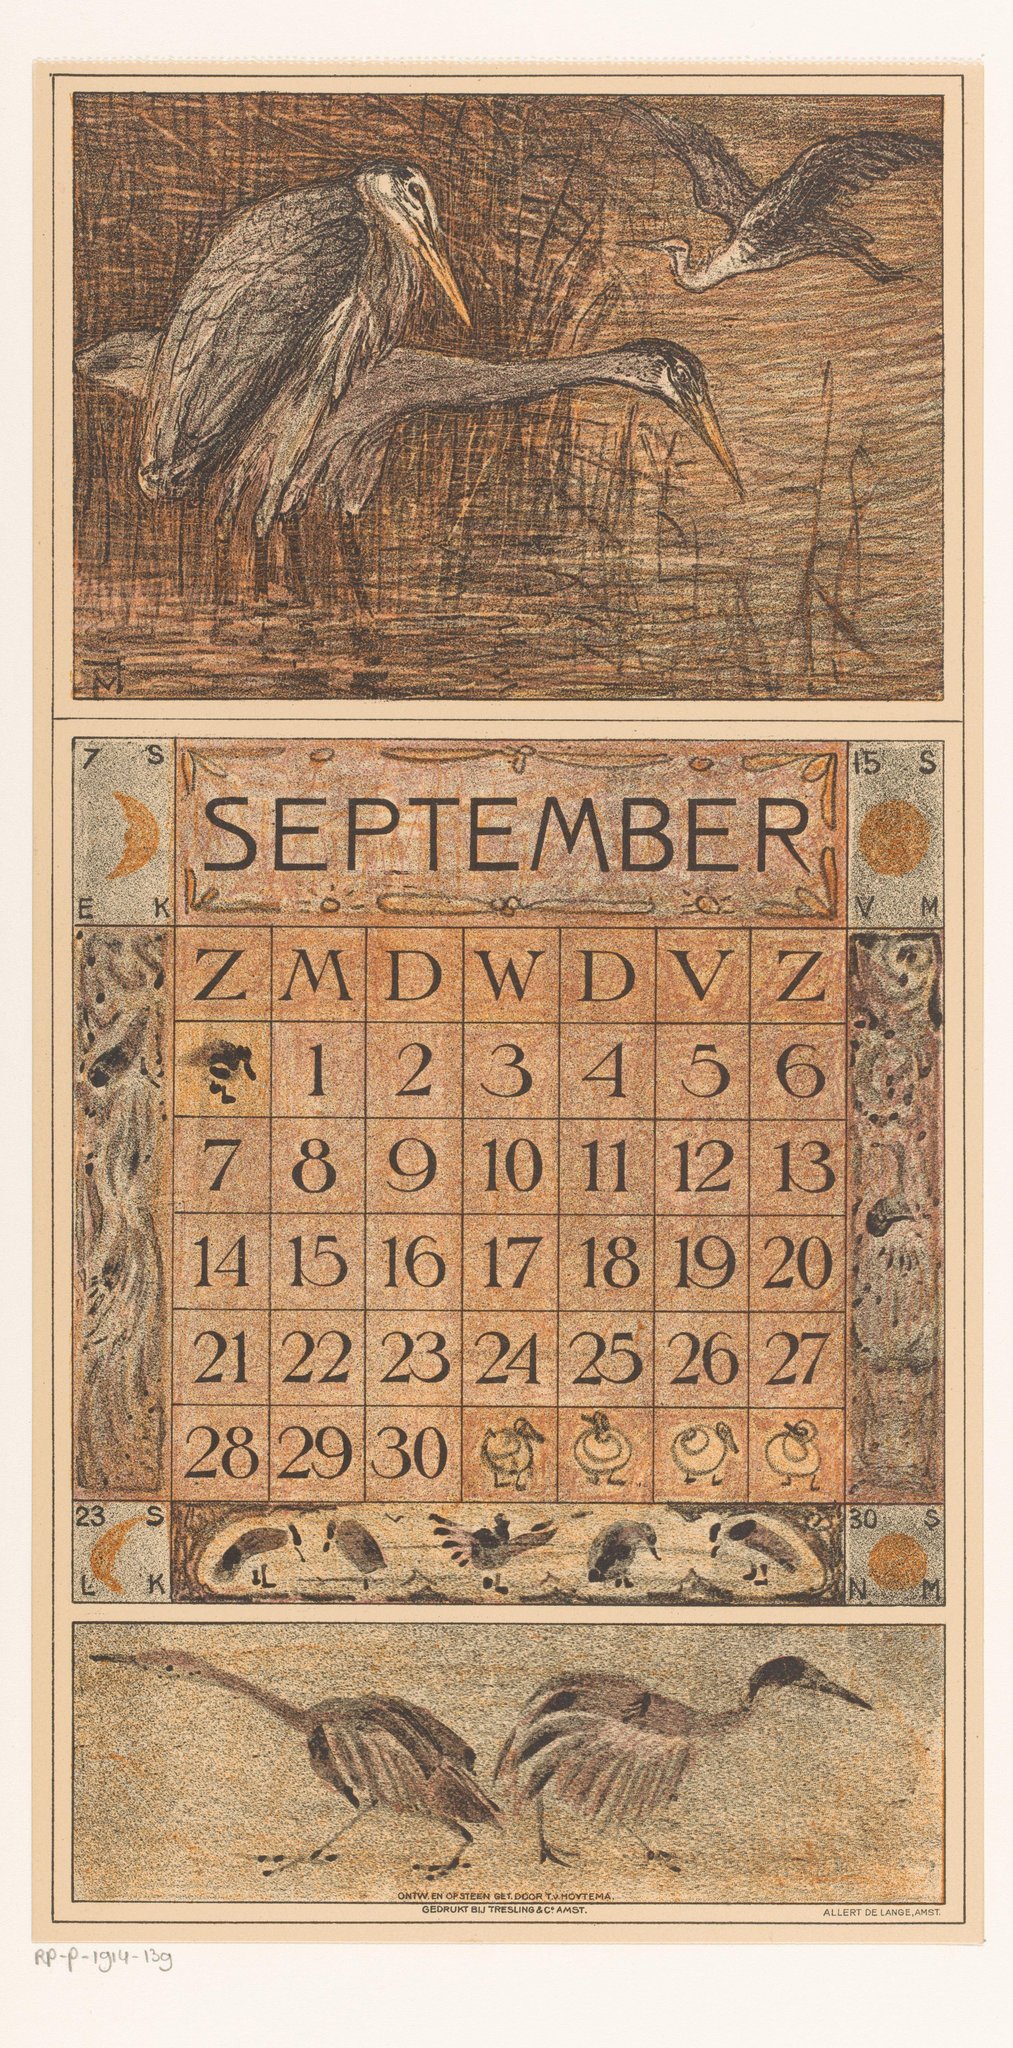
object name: print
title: Kalenderblad september met reigers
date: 1912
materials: paper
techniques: lithograph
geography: amsterdam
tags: shore-birds and wading-birds: heron, lunar year, plants and herbs: reed, september ~ other concepts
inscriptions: collector's mark: Lugt 2228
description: De reigers staan tussen het riet. In de hoeken de standen van de maan op vier dagen. Bovenaan het blad een scheurlijn.